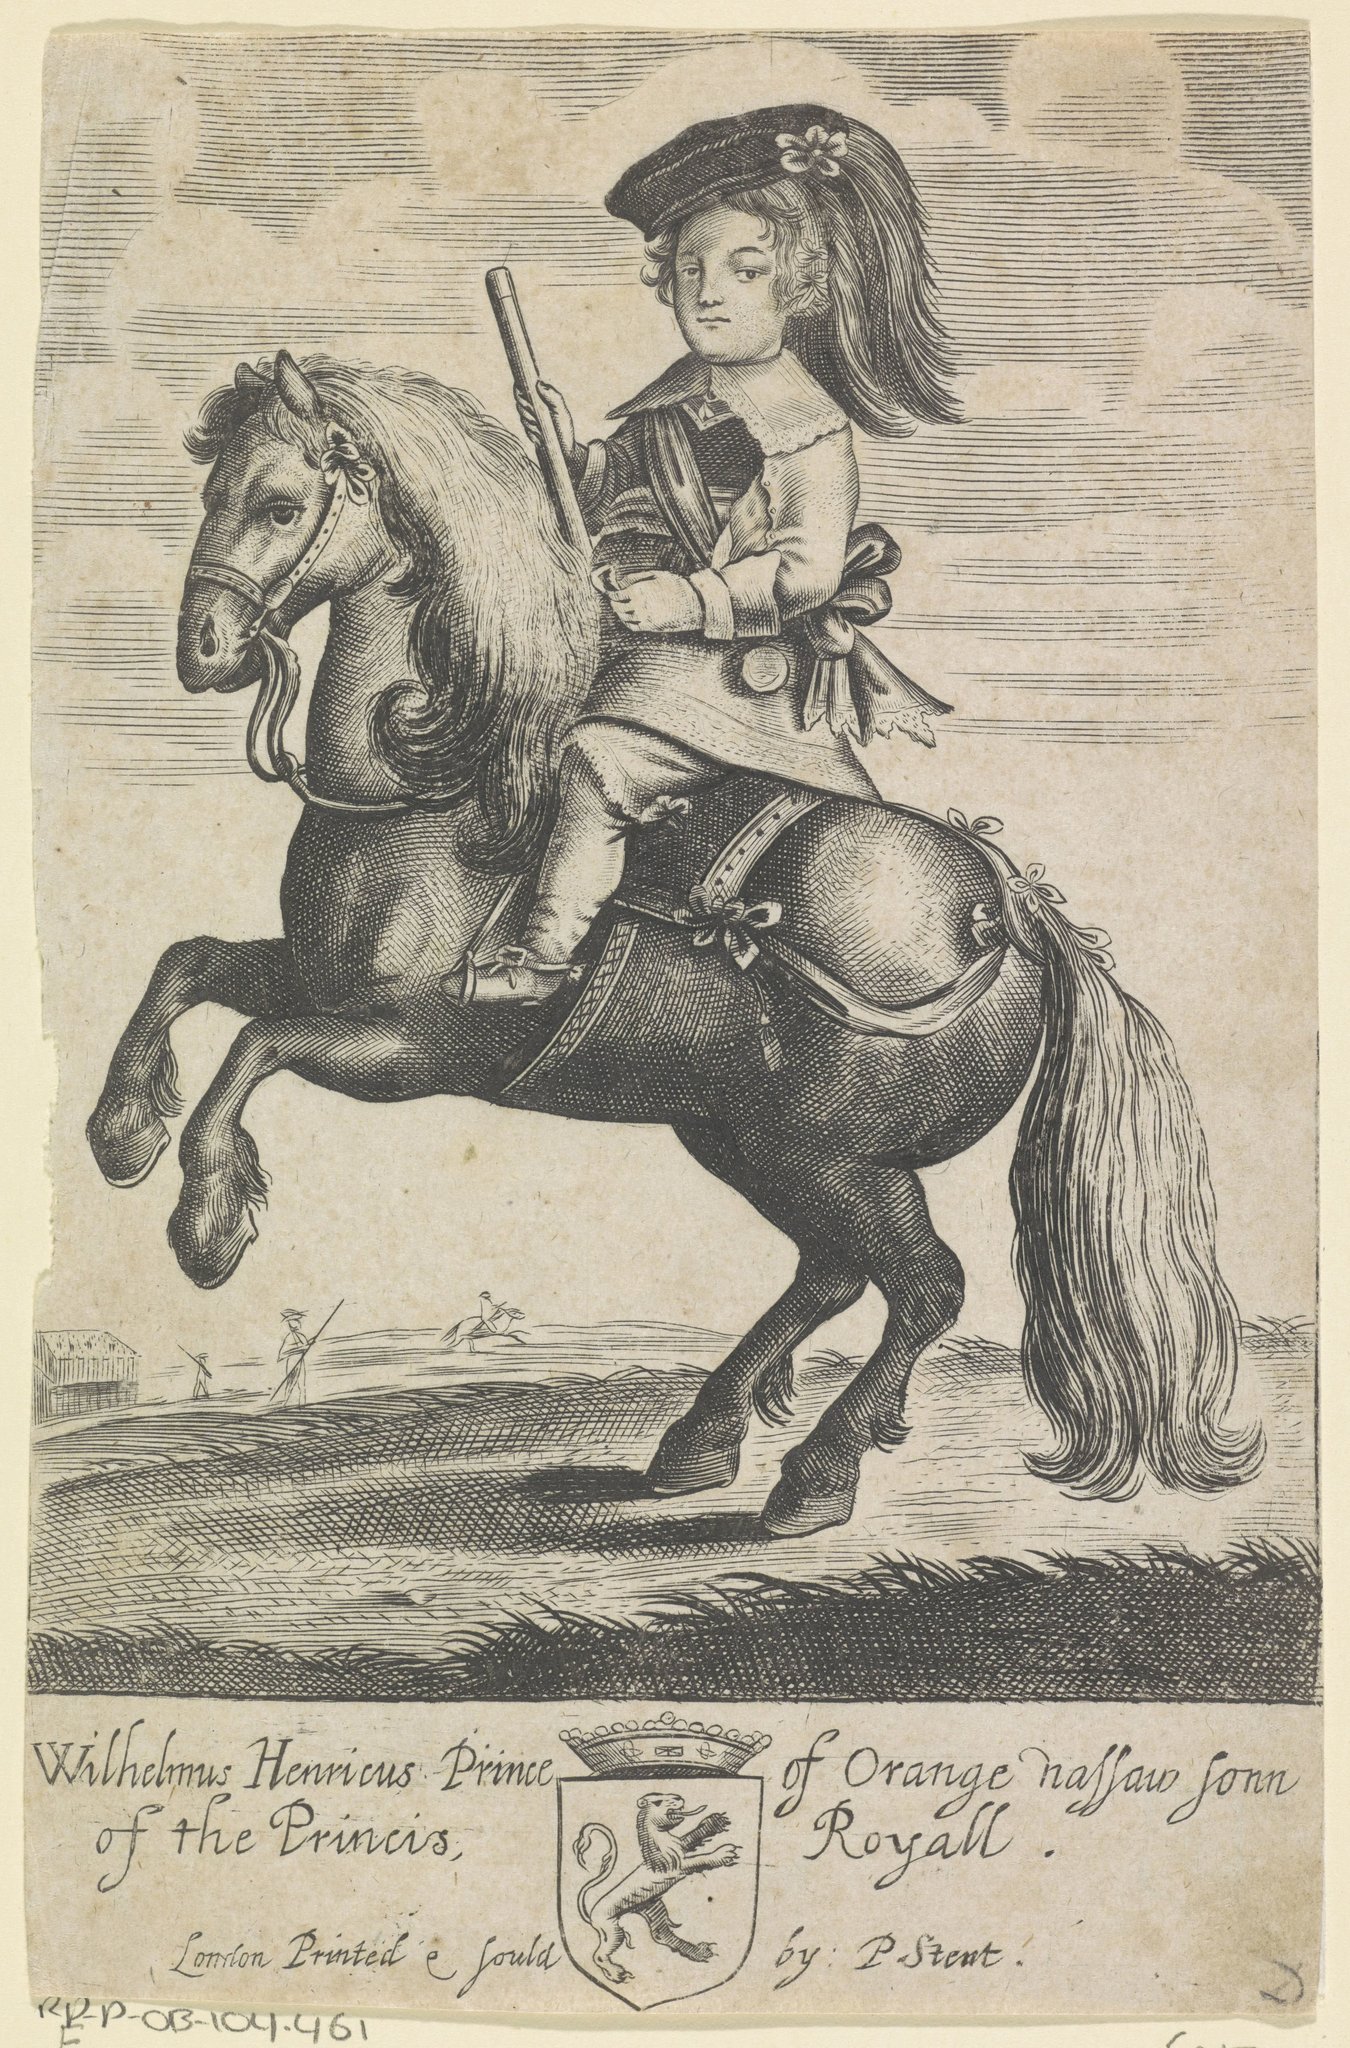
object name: print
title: Ruiterportret van Willem III, prins van Oranje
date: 1655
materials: paper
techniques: engraving, etching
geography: london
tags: the hague, william iii (prince of orange and king of england, scotland, and ireland)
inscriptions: collector's mark: Lugt 963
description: De hier vermelde titel verwijst naar de hoogst verkregen titel van de geportretteerde, niet per se naar de titel die de geportretteerde op deze voorstelling draagt.